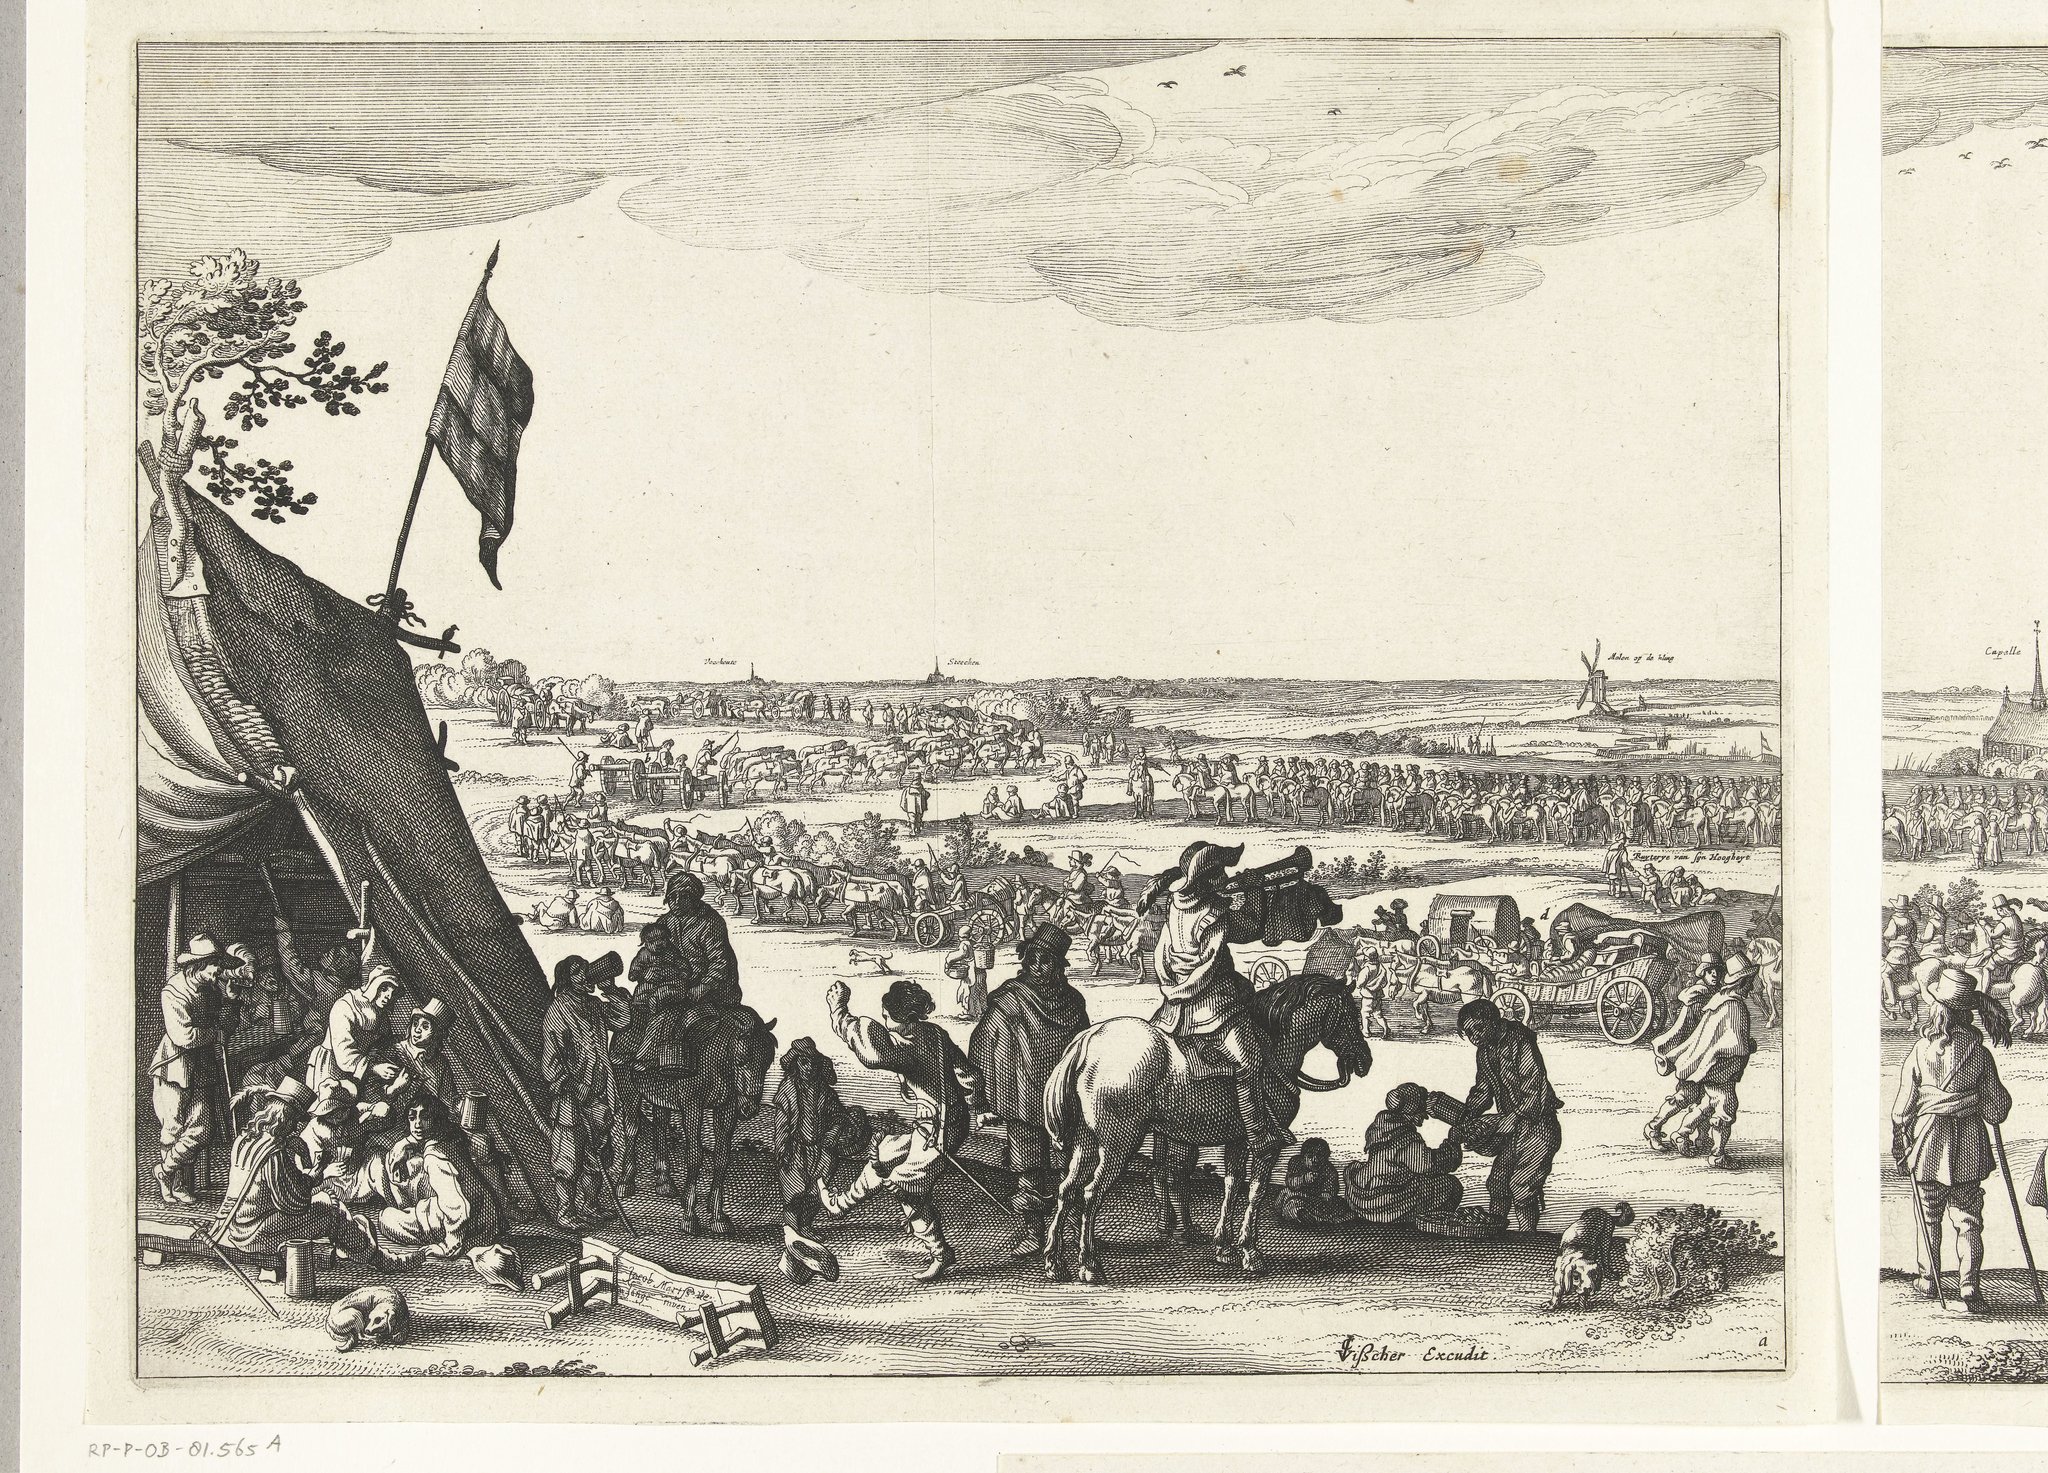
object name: print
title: Uittocht van het Spaanse garnizoen uit Hulst (blad a), 1645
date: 1645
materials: paper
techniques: etching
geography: amsterdam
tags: delft, the hague, frederick henry (prince of orange), recreation ~ the soldier off duty, retreat of the defeated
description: Uittocht van het Spaanse garnizoen uit Hulst (blad a), 1645. Hulst, belegerd door het Staatse leger onder Frederik Hendrik vanaf 28 september en ingenomen op 5 november 1645. Linkerblad in een voorstelling bestaande uit drie bladen. Op de voorgrond een tent met drinkende, kaartende en dansende Staatse soldaten en een trompetter. Op de achtergrond de stoet met goederenwagens en ruiters. Wellicht onderdeel van een ongemonteerd ensemble bestaande uit de twee kaarten, het profiel, het blad met de zes forten, de drie bladen van de uittocht van het garnizoen en de twee tekstbladen.